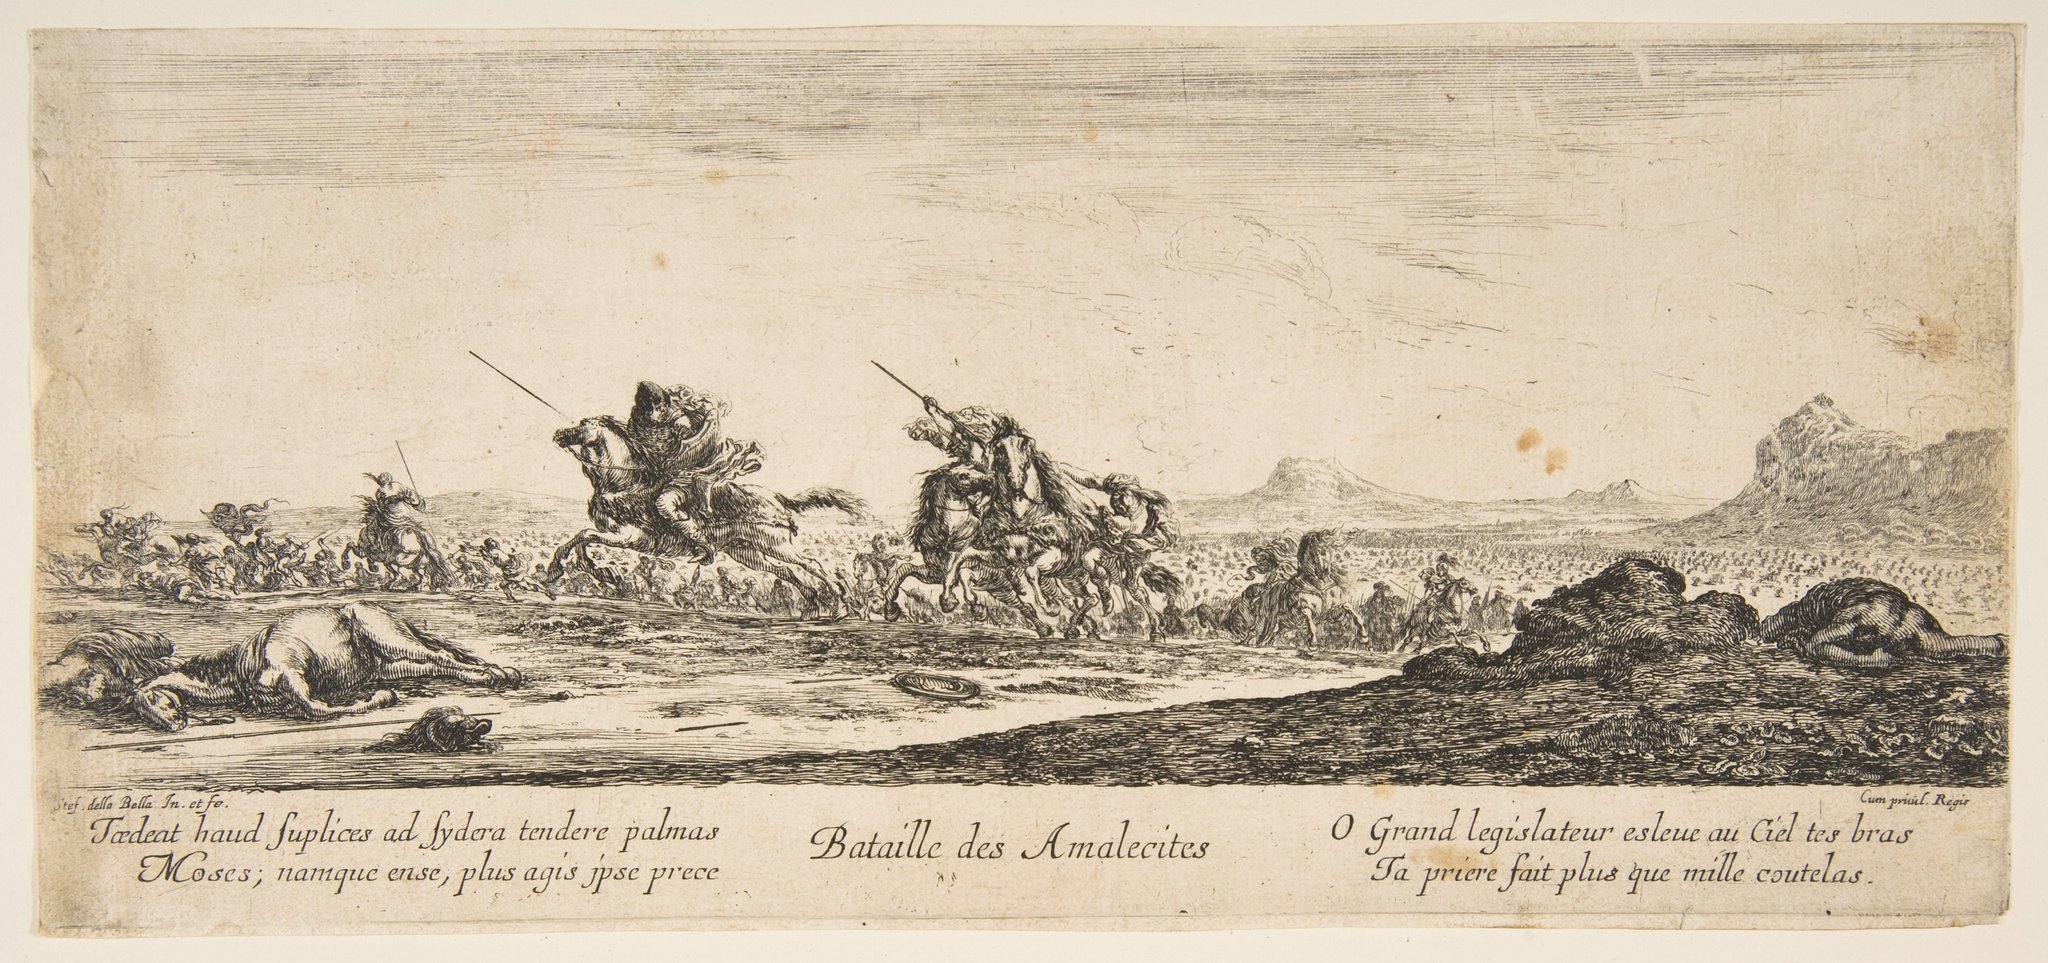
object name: print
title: The Battle of the Amalekites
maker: stefano della bella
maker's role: artist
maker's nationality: italian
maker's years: 1610-1664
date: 1645-1652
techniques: etching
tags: battles,soldiers,horses